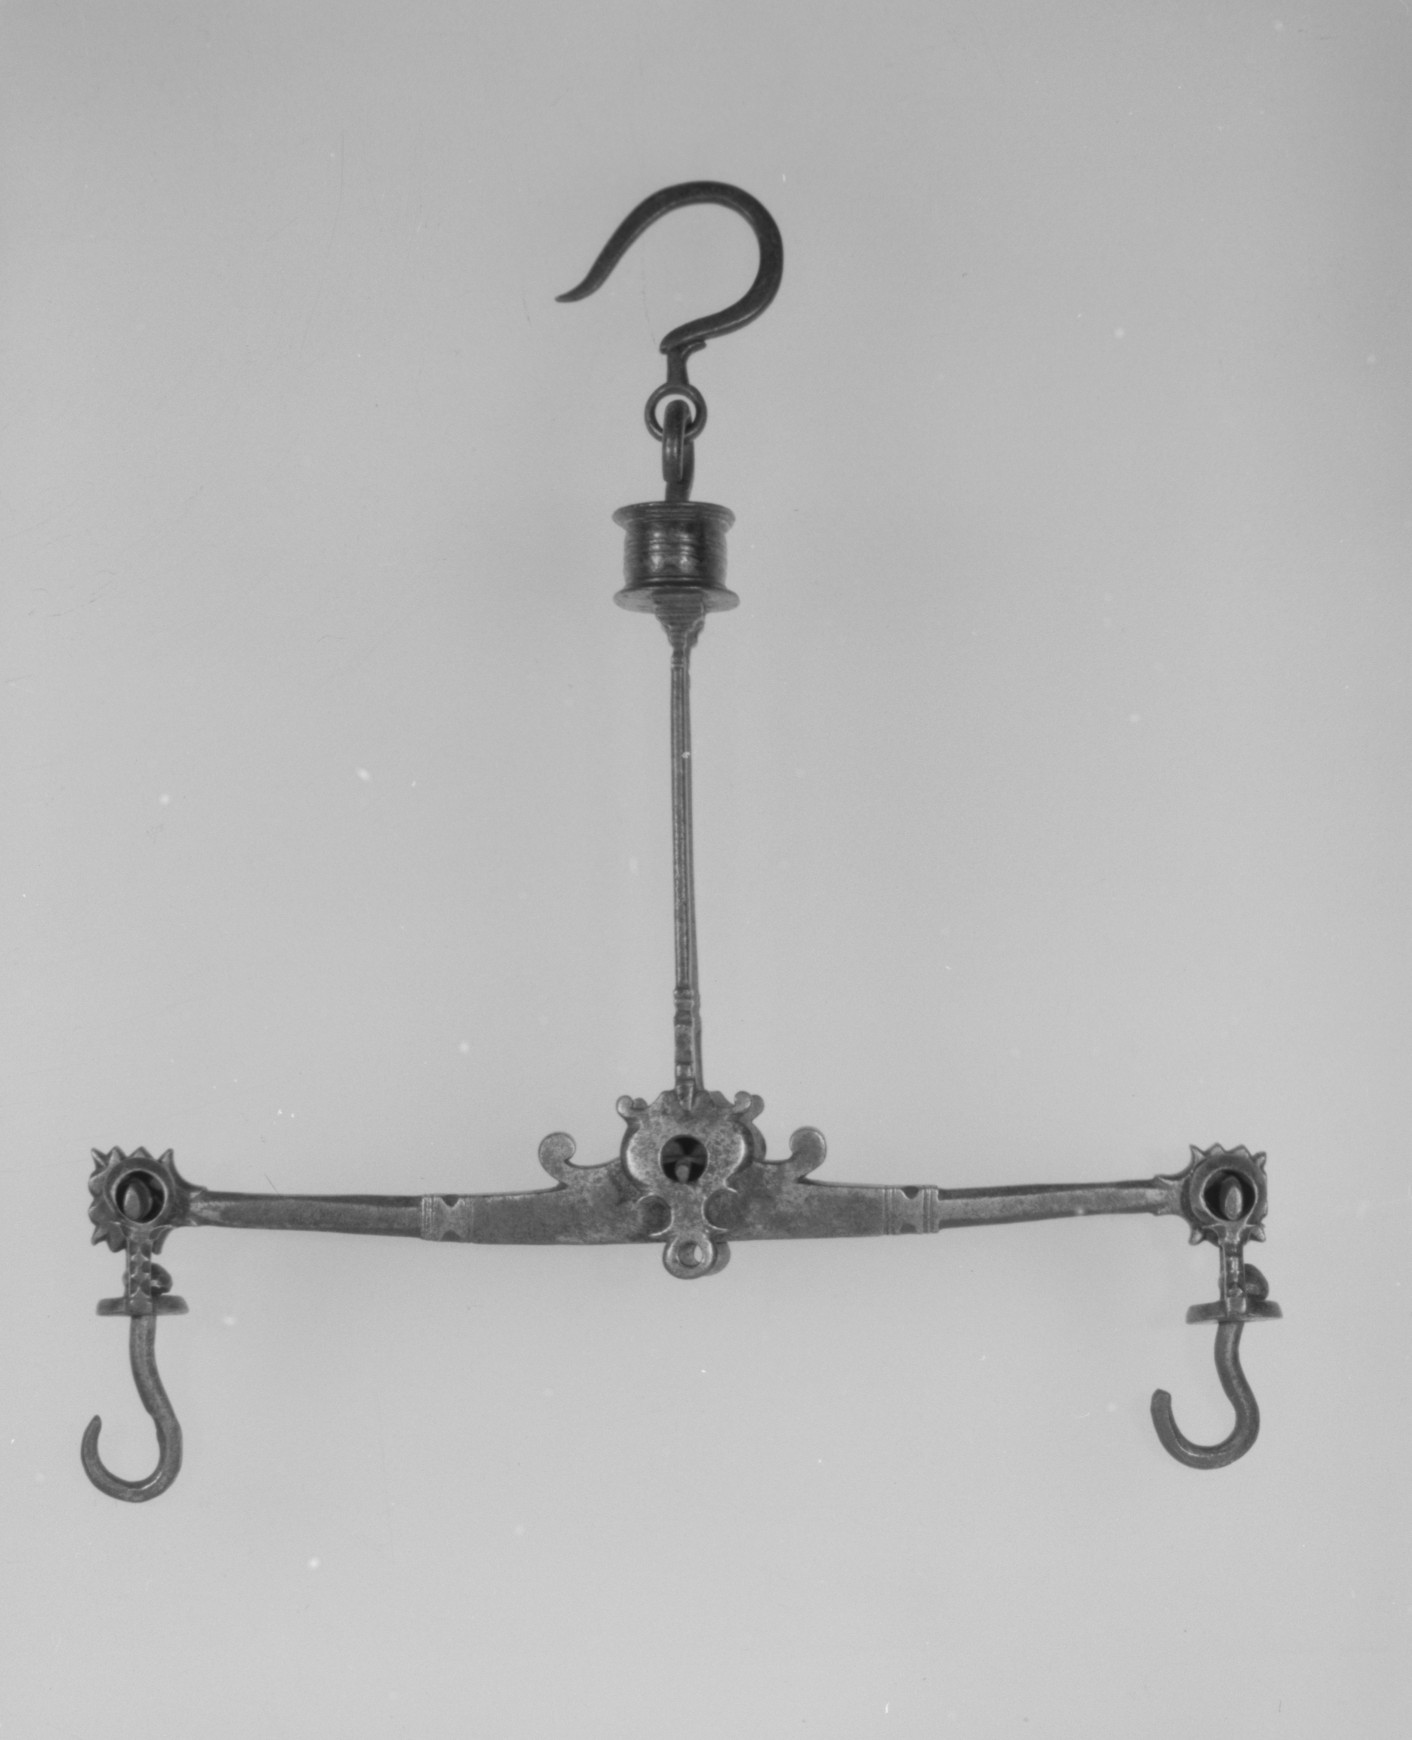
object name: scale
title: Scales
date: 1501-1600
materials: iron